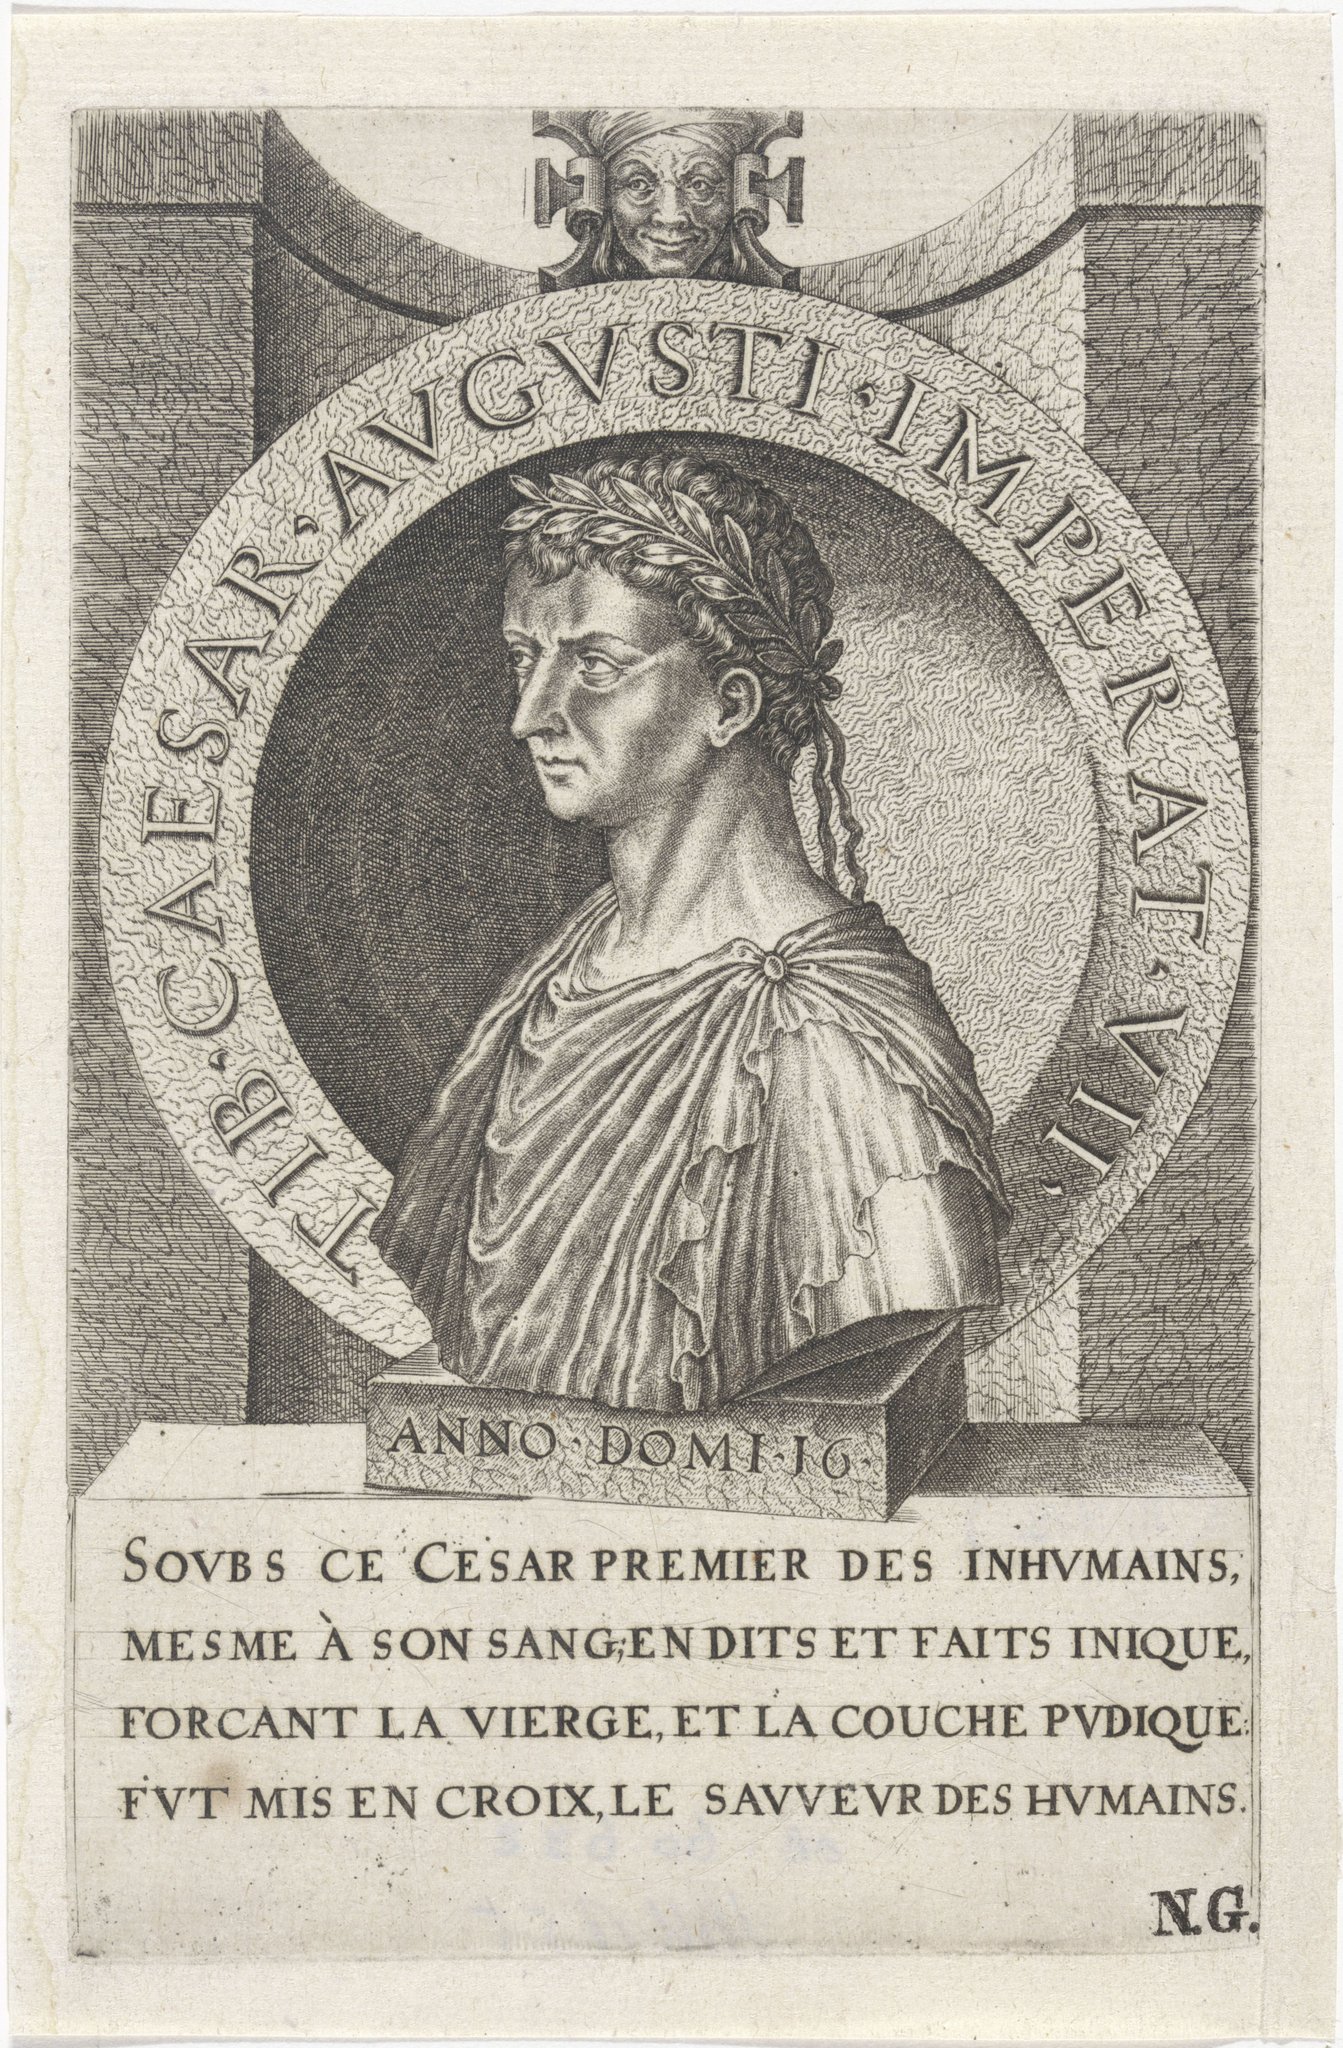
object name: print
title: Romeinse keizers en keizerinnen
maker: lambertus suavius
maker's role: print maker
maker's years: 1514-1564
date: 1520-1567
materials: paper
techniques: engraving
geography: southern netherlands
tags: miseno, emperor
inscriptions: collector's mark: Lugt 2228, collector's mark: Lugt 1967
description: Buste van keizer Tiberius van het Romeinse Rijk, voor een nis. Midden boven een masker. Onderaan een vierregelige tekst in het Frans.